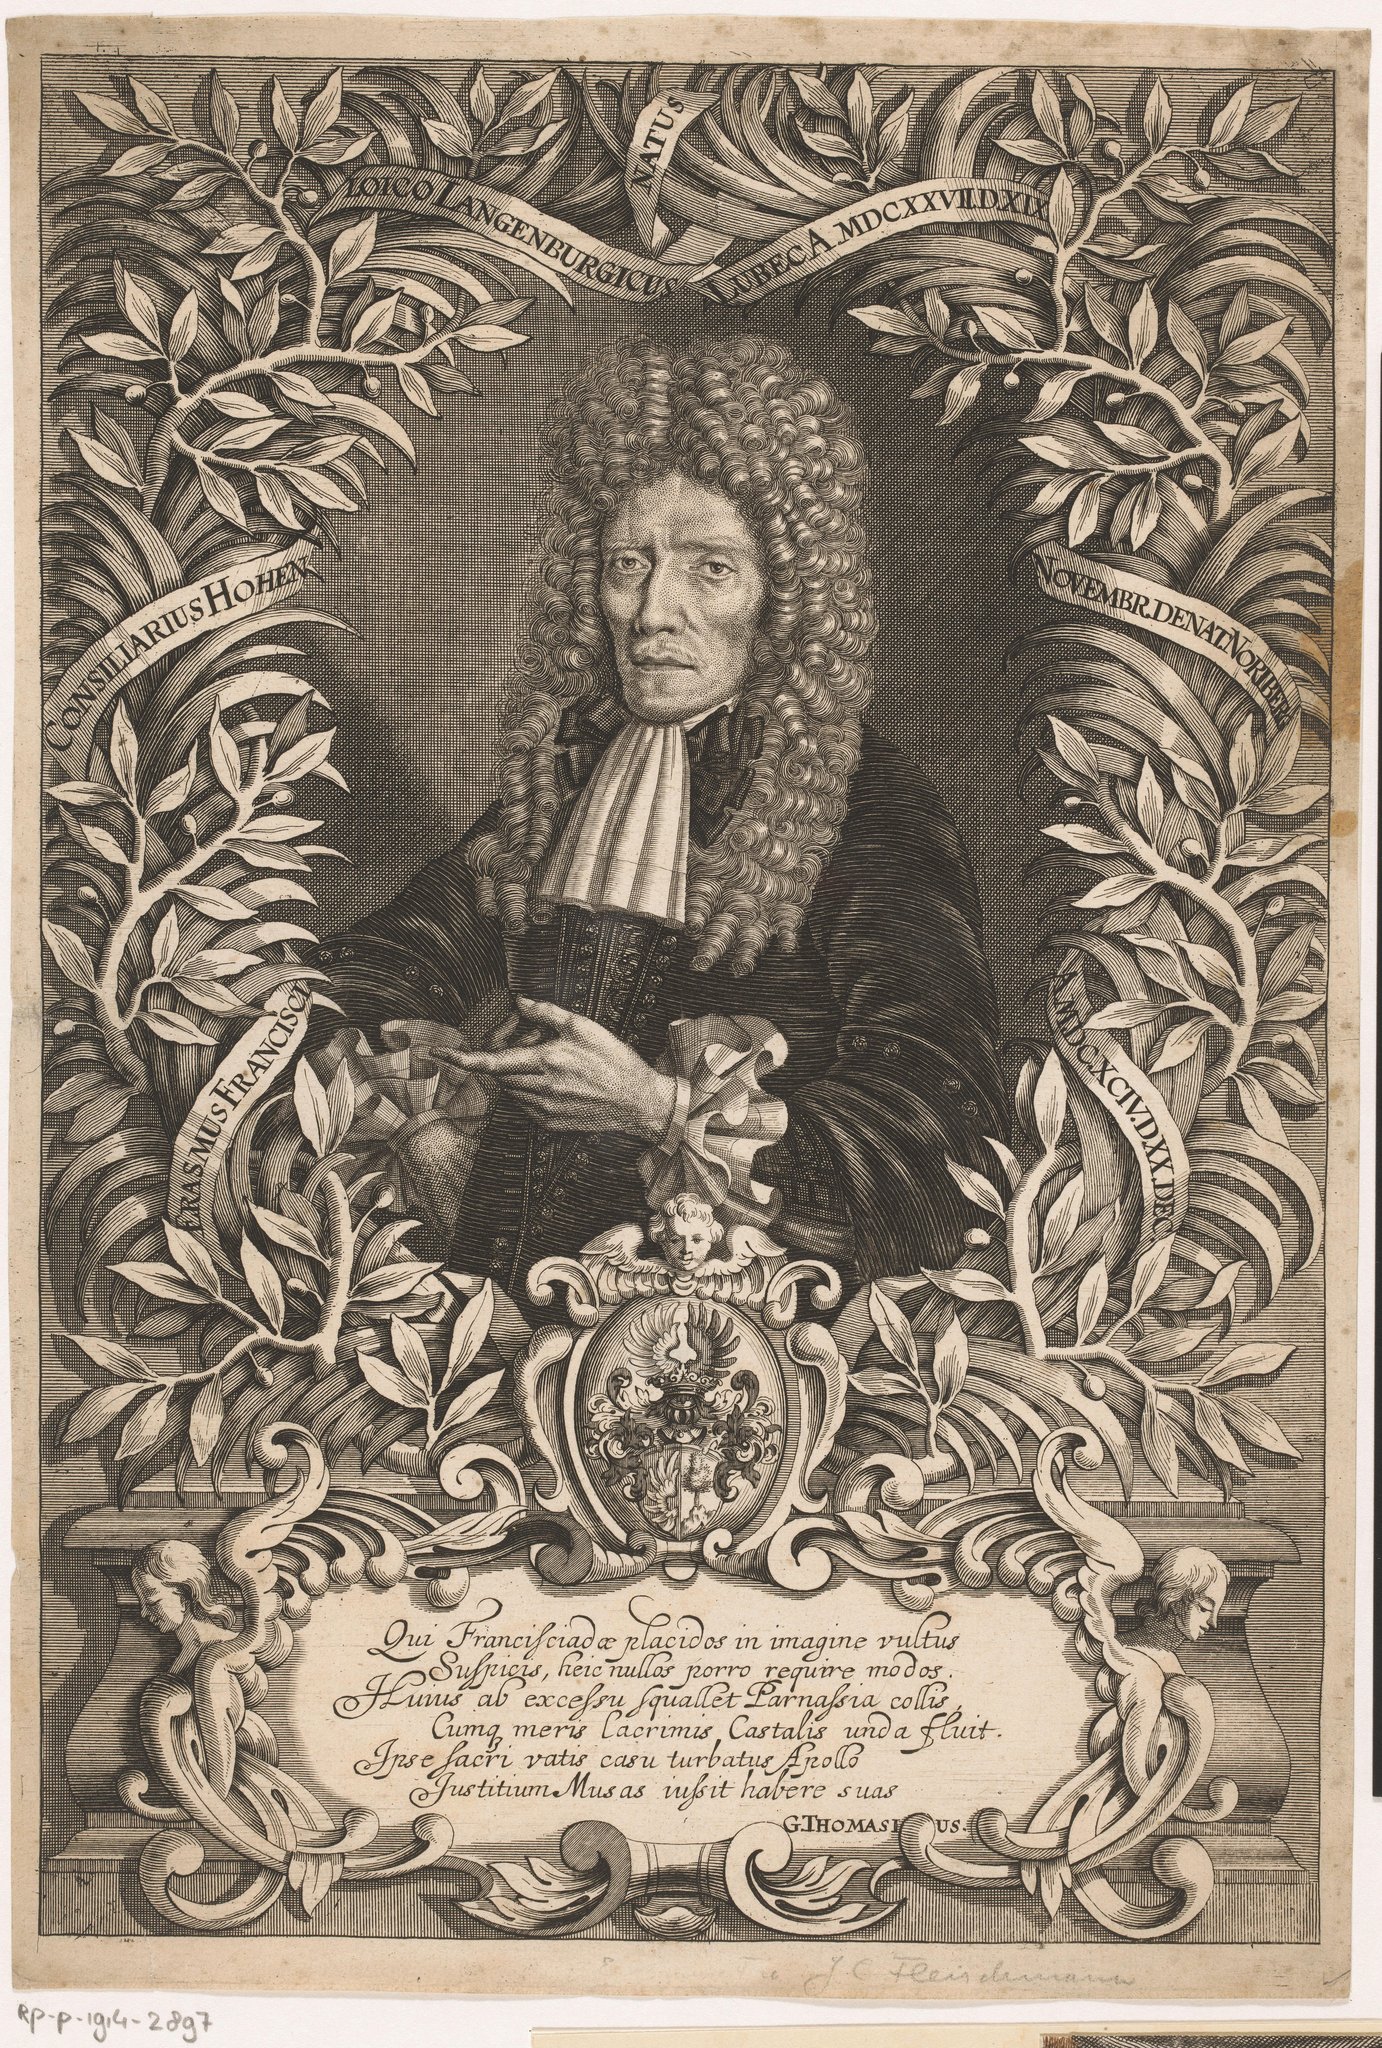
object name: print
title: Portret van Erasmus Francisci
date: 1704-1732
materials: paper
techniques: engraving, etching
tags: erasmus finx, cherubs, i.e. children's heads with wings, historical persons, ornament ~ cartouche, armorial bearing, heraldry, trees: olive-tree (+ branch, stick)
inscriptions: collector's mark: Lugt 2228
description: Portret in florale omlijsting, met onder in cartouche een lofdicht in het Latijn.